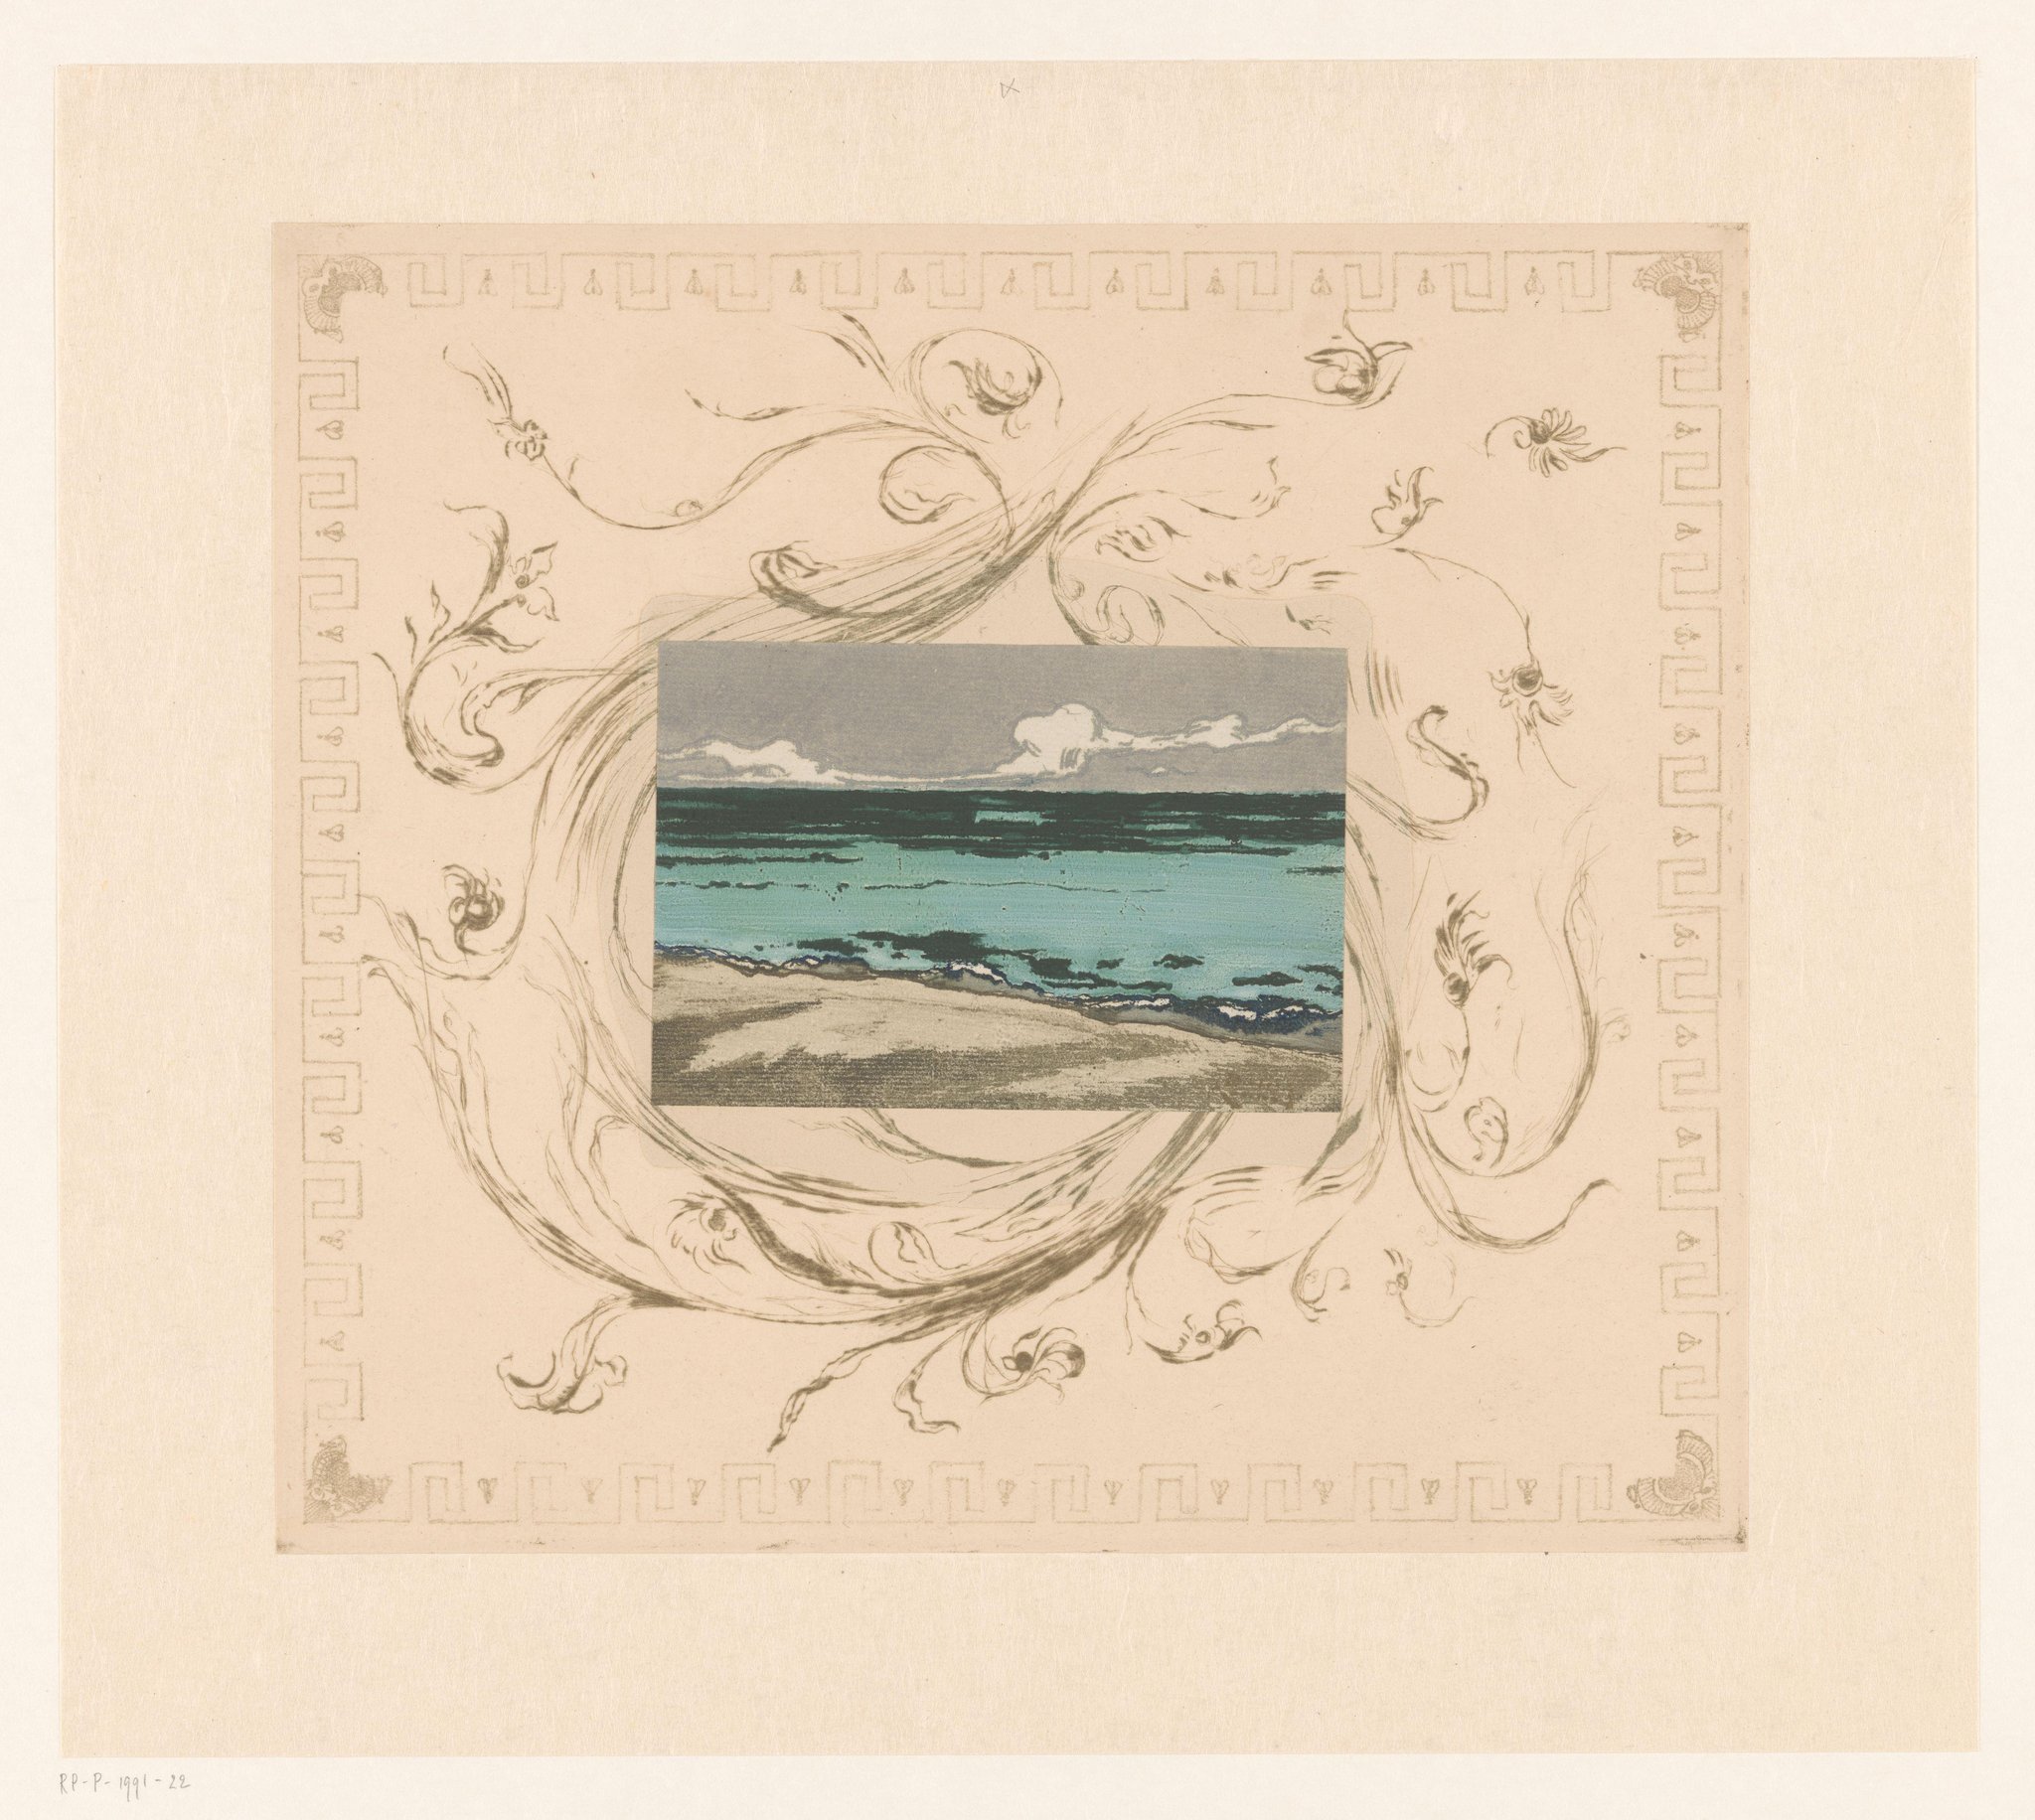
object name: print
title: The sea at Bognor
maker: théodore roussel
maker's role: print maker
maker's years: 1847-1926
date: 1895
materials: paper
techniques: aquatint, drypoint, etching, soft ground etching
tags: coast